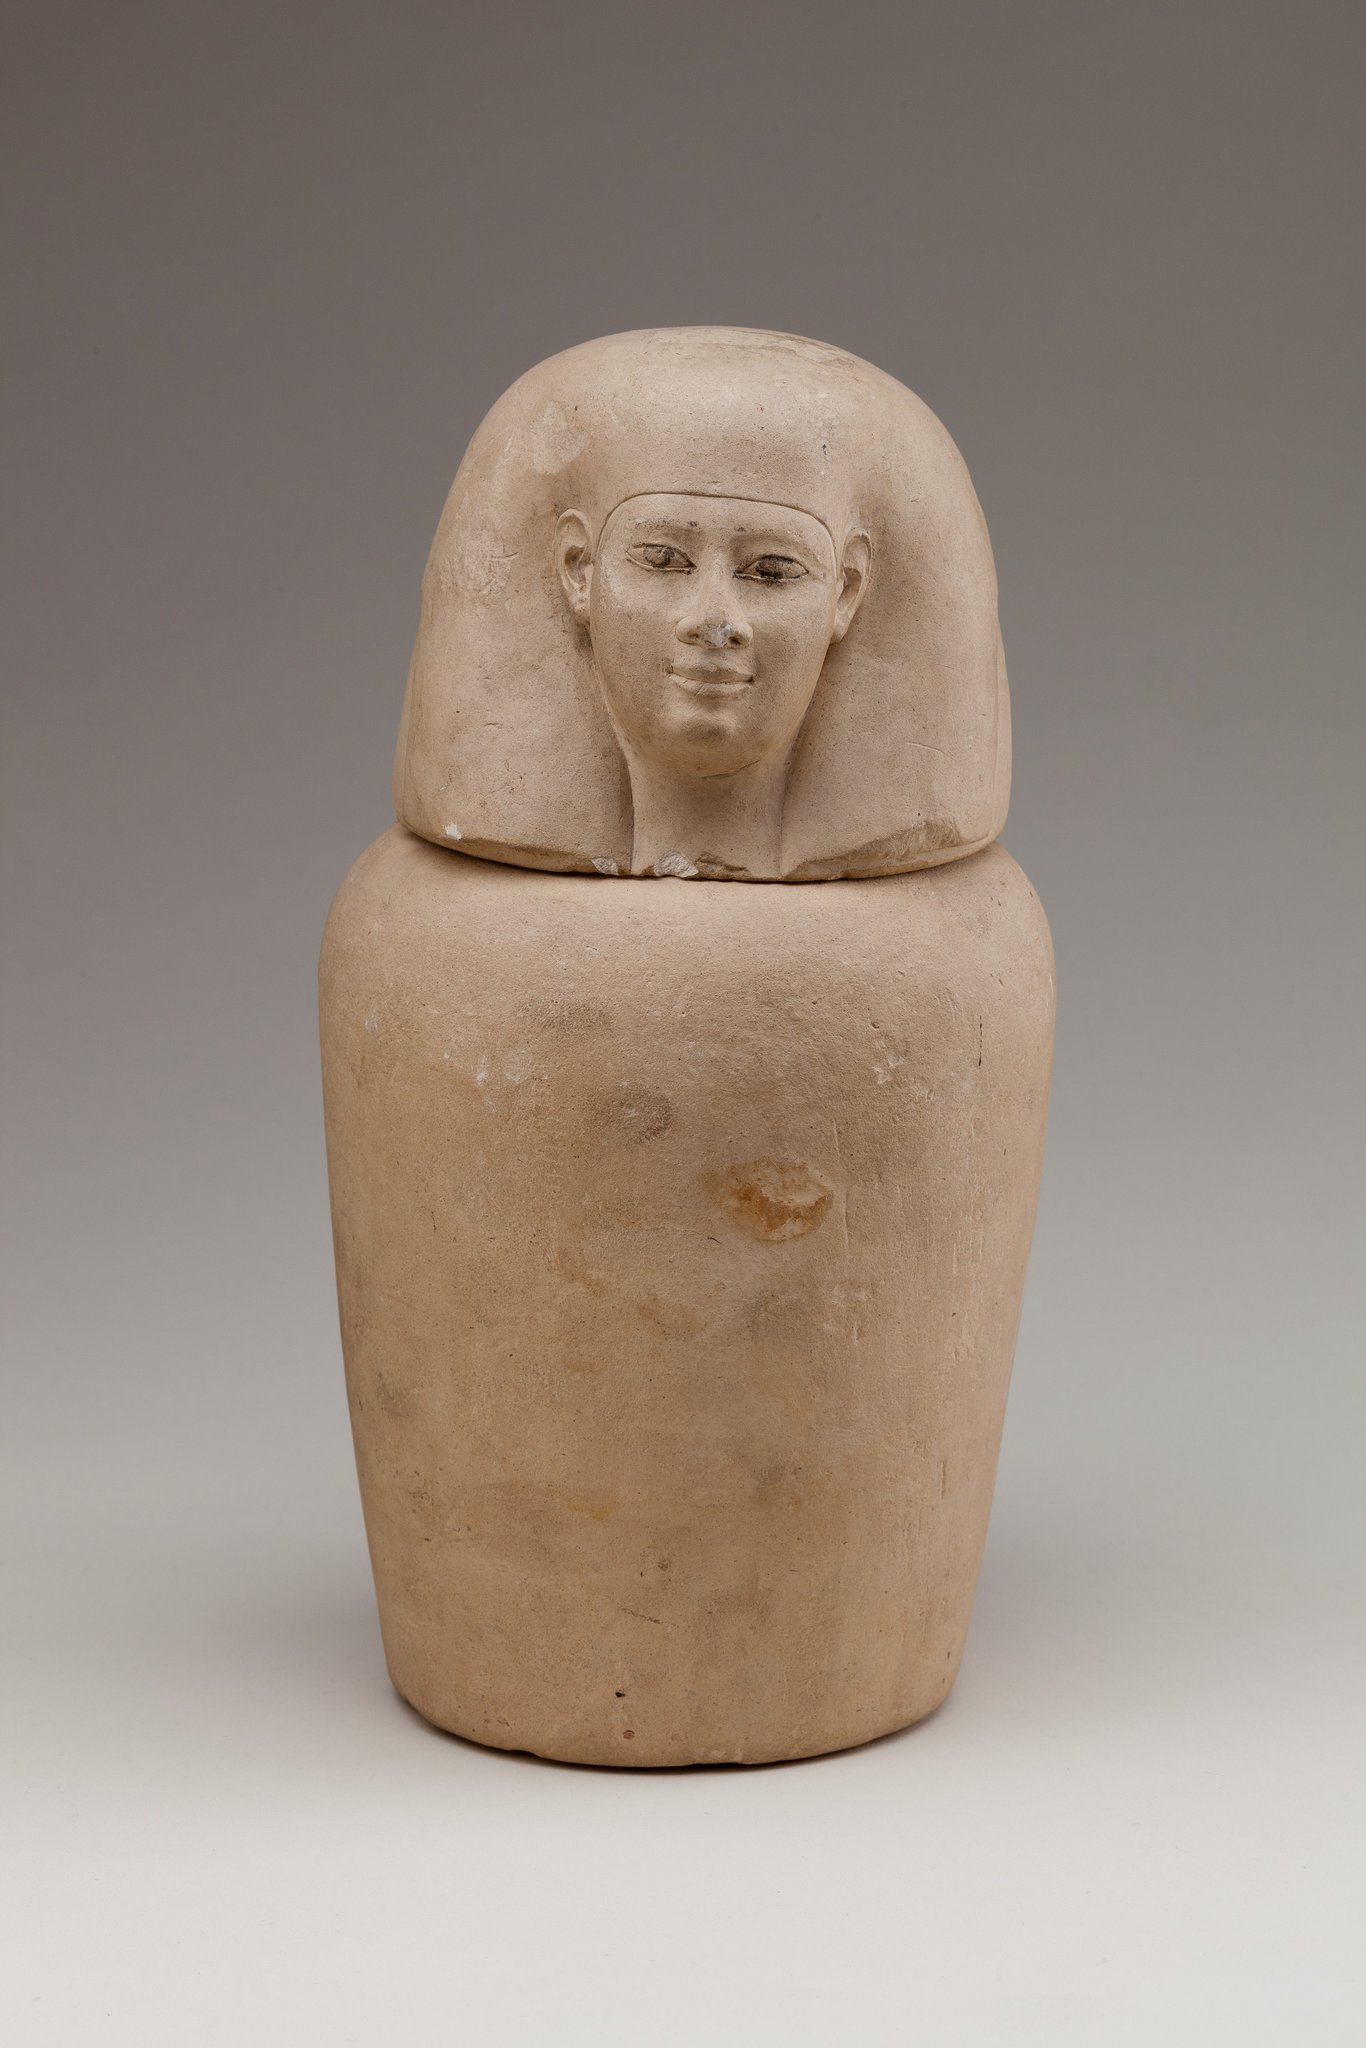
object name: canopic jar, imseti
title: Canopic Jar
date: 664-525 BCE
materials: limestone, paint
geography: northern upper egypt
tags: funerals